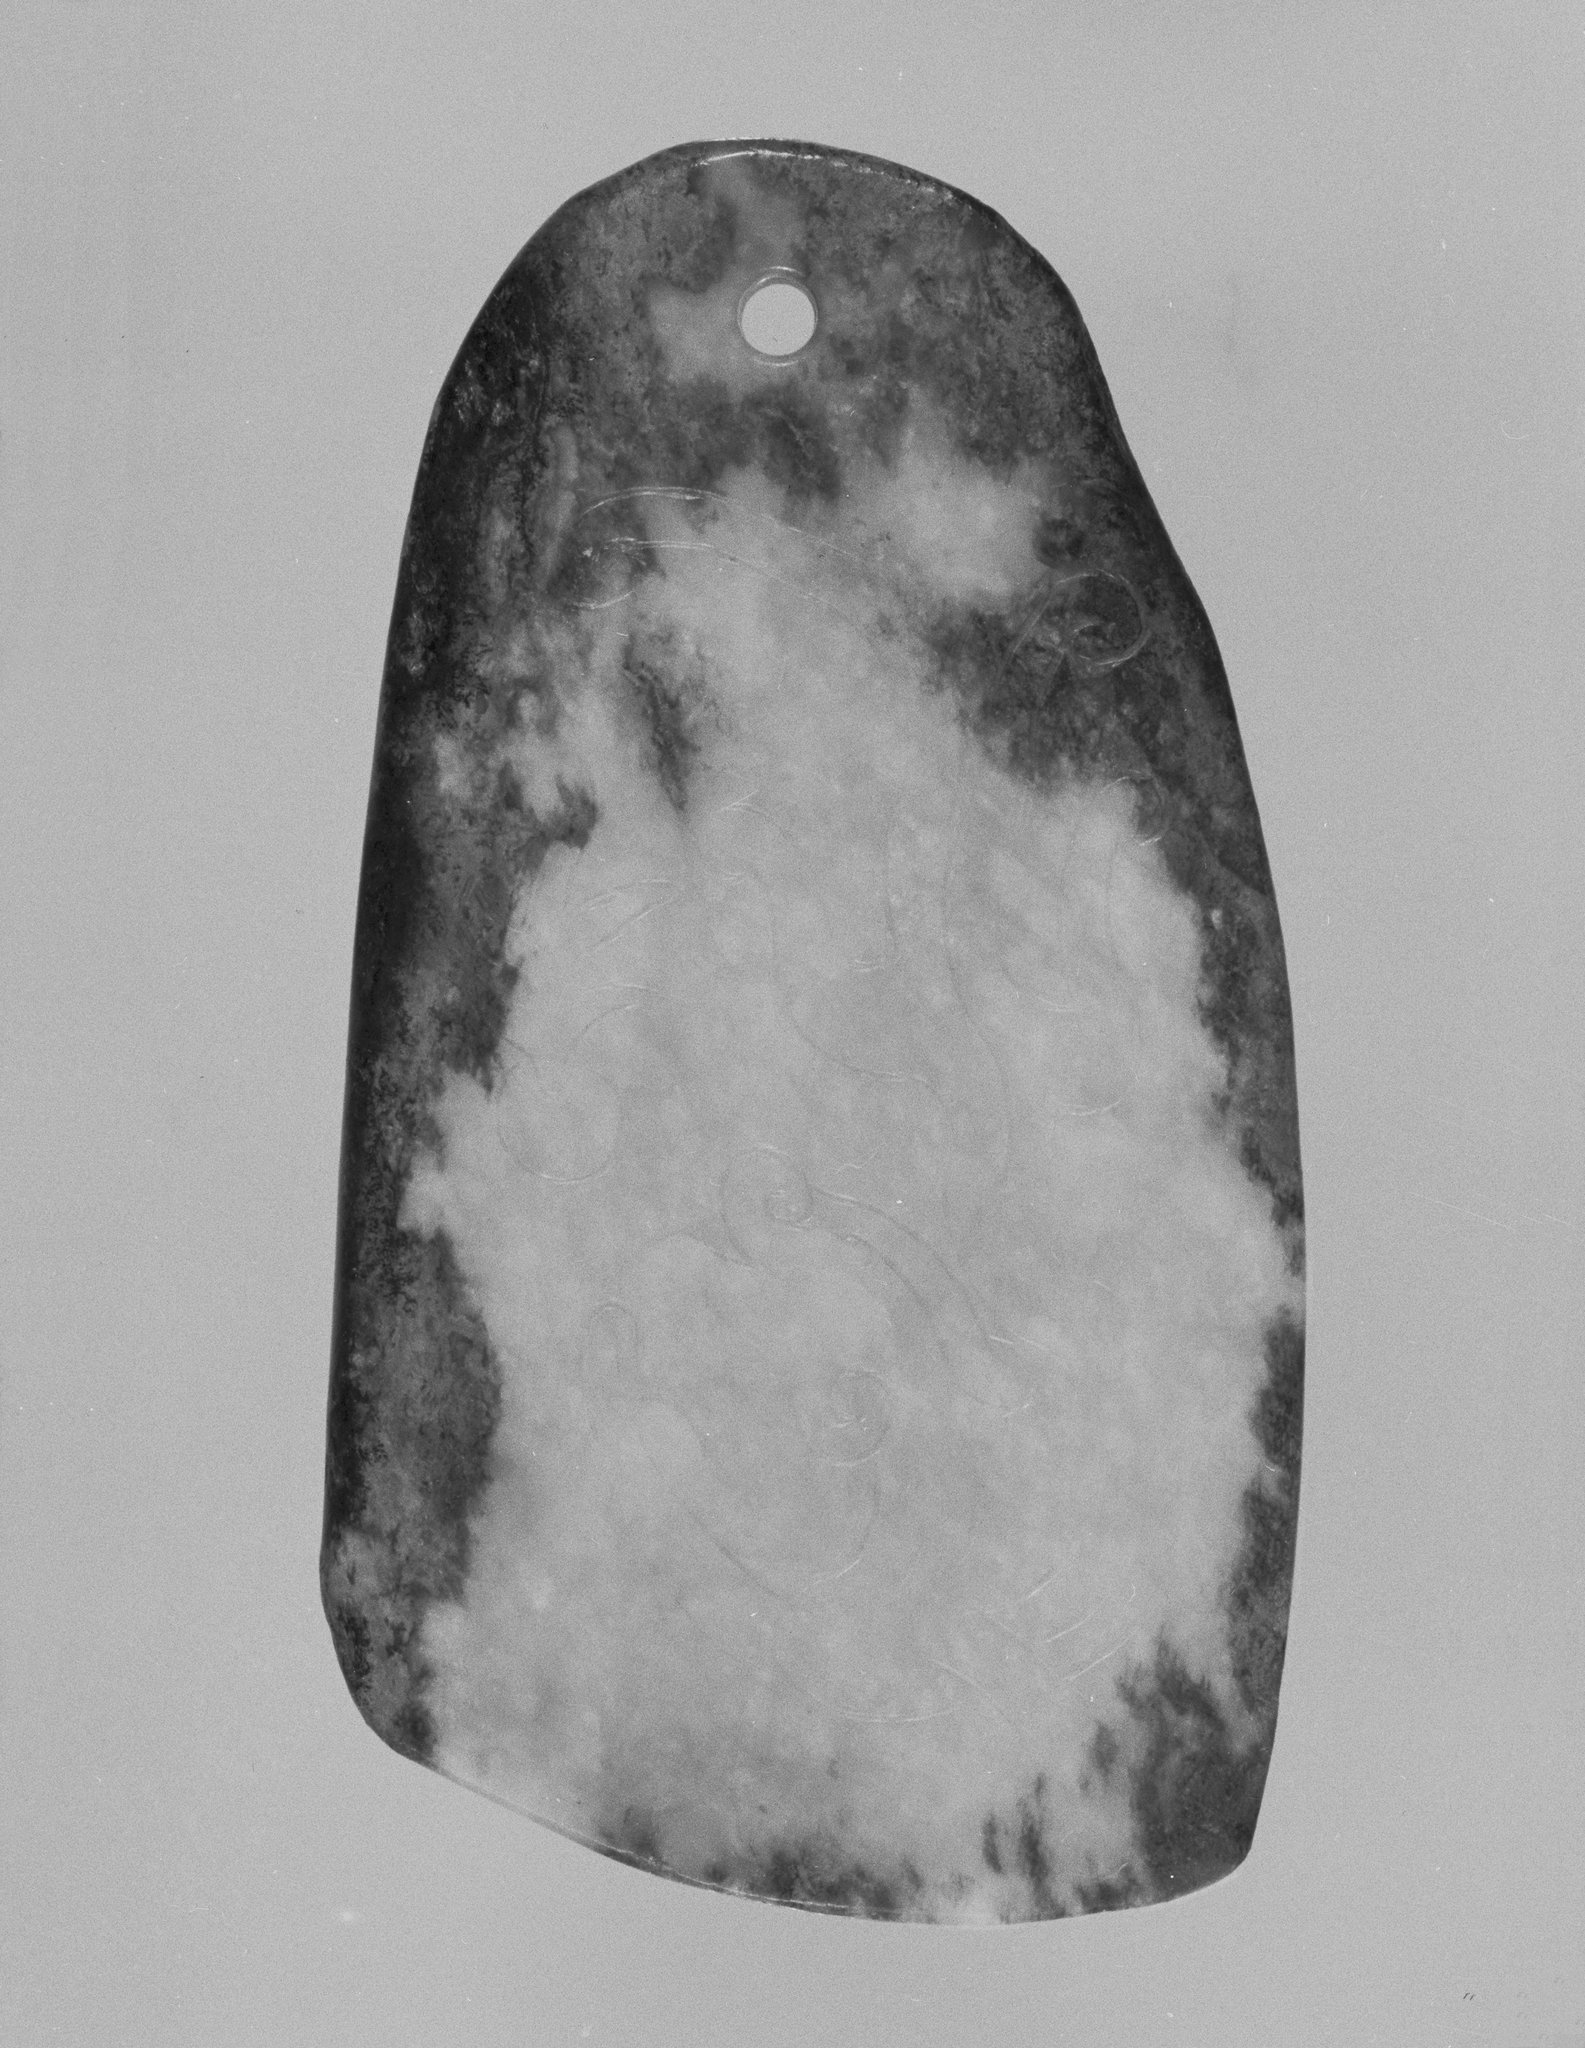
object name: pendant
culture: chinese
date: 1701-1800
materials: jade